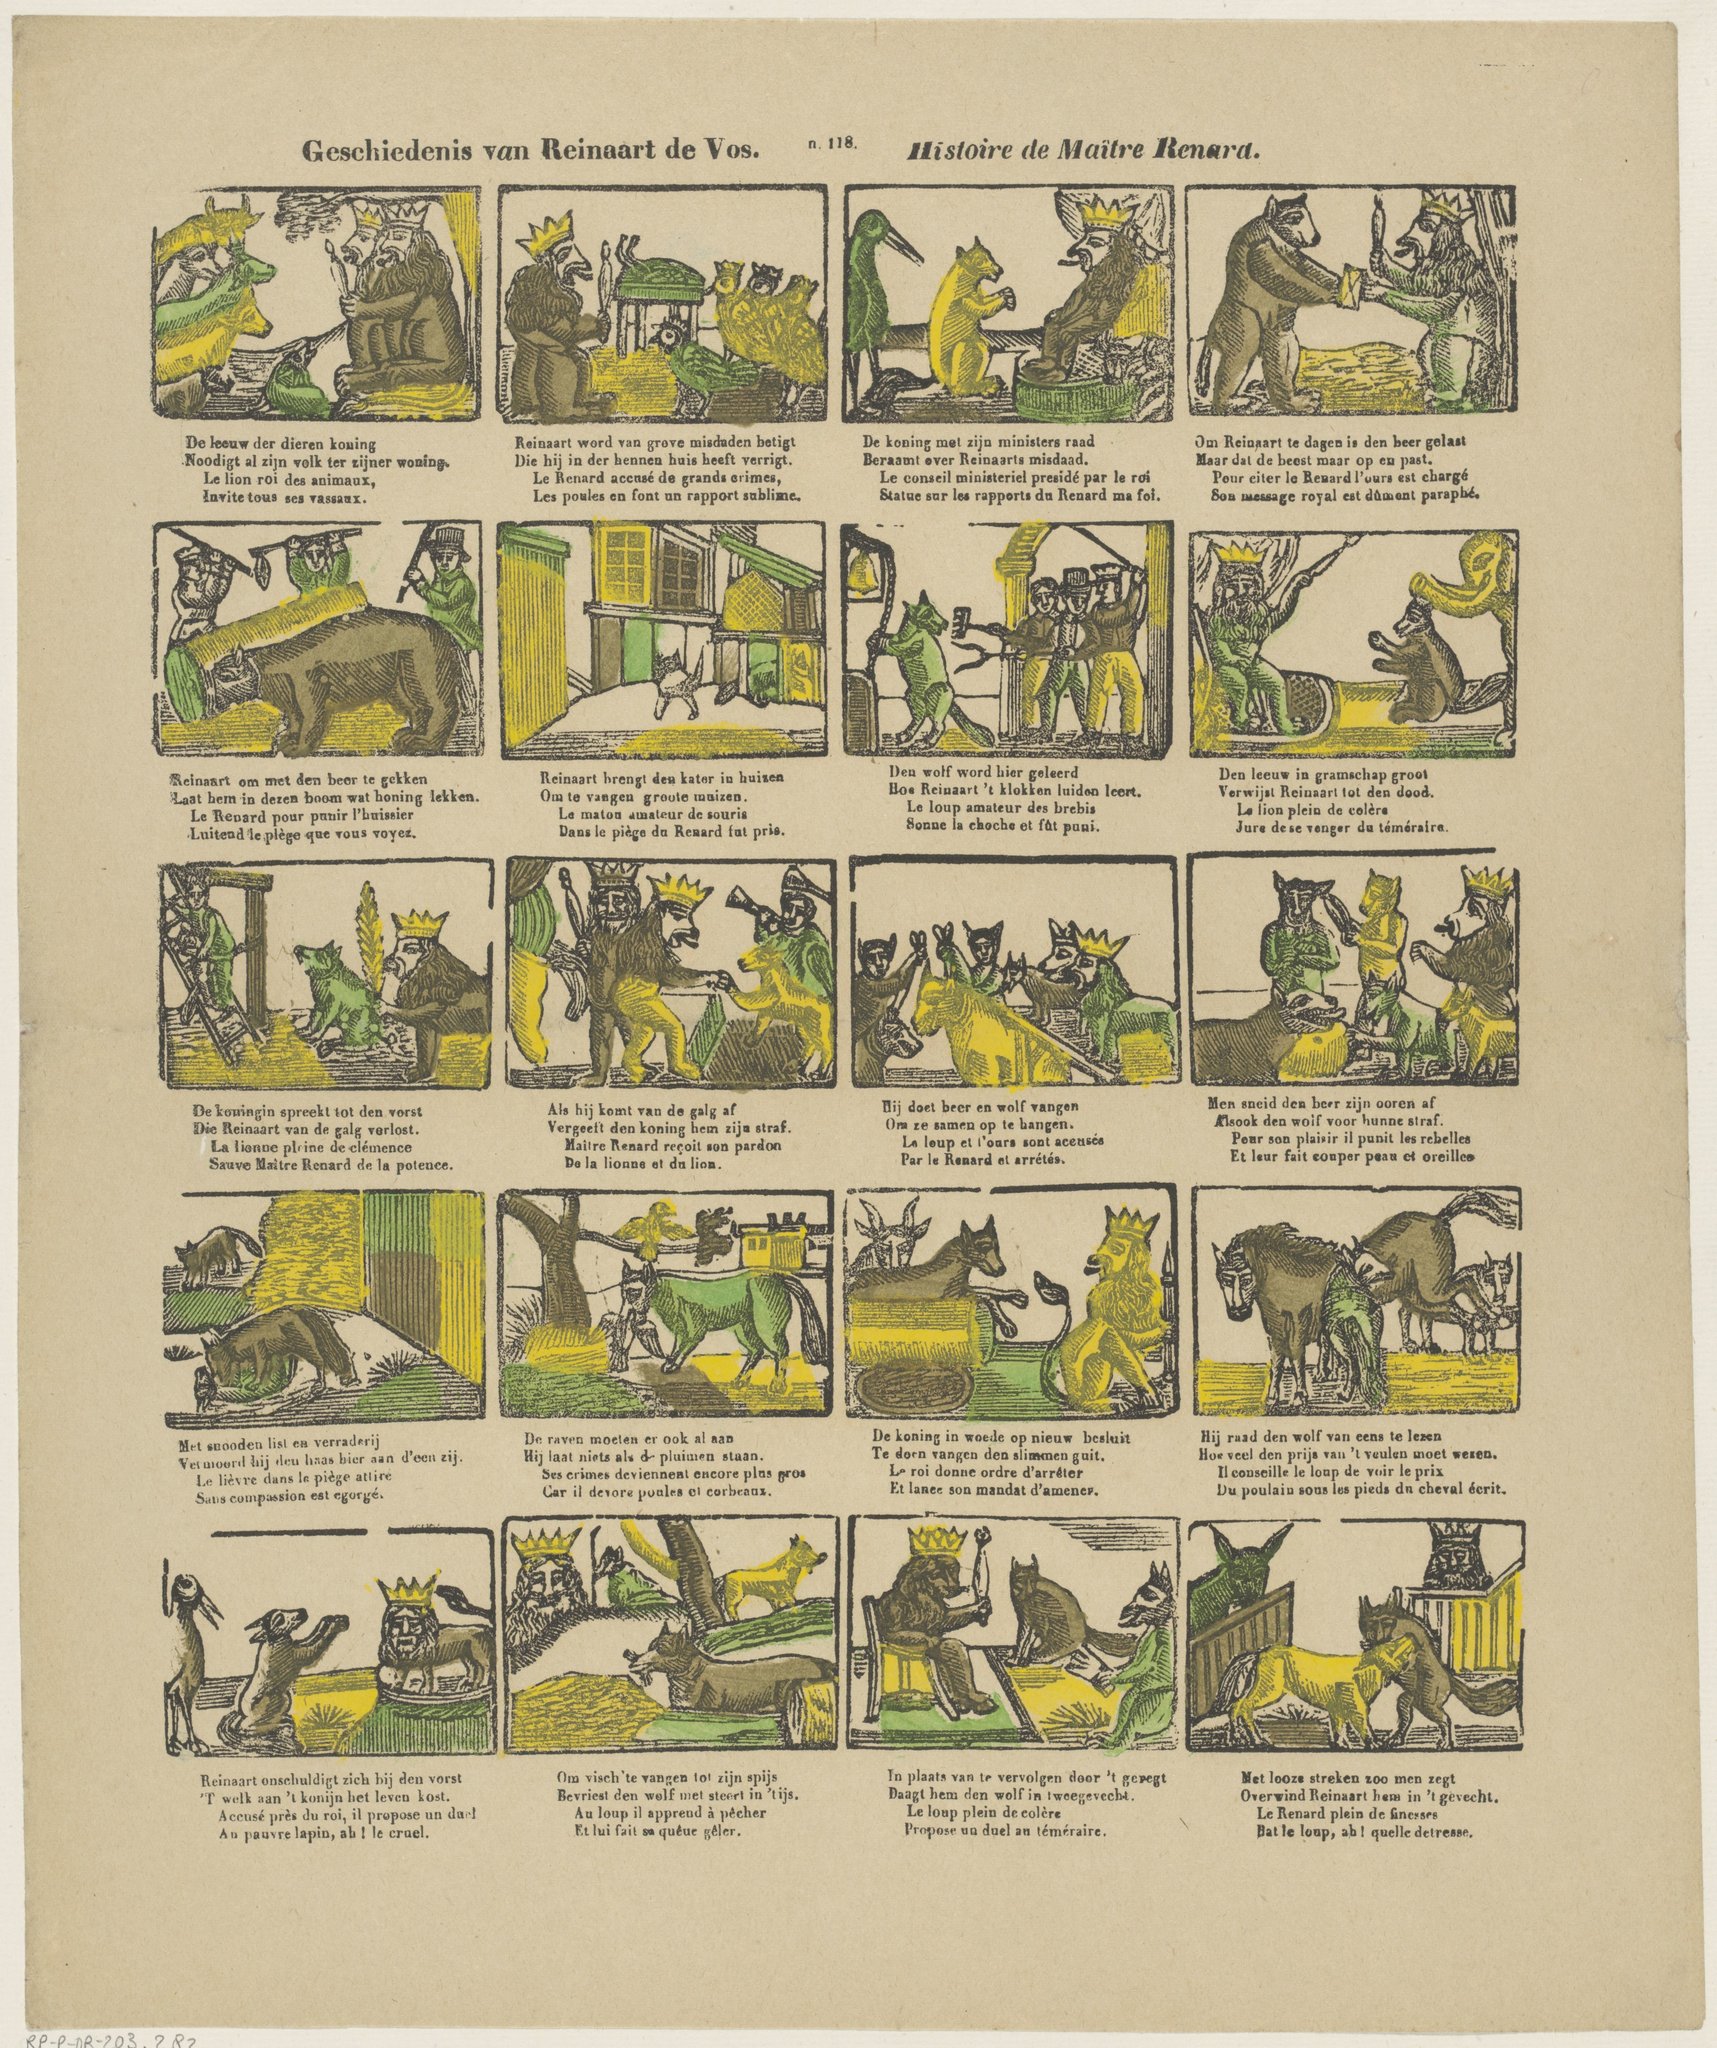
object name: print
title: Geschiedenis van Reinaert de vos / Histoire de mâitre Renard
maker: Anonymous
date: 1856-1900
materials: paper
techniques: colour, letterpress printing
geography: turnhout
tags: fable of reynard the fox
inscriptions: collector's mark: Lugt 2760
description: Blad met 20 voorstellingen uit het epos van Reinaert de vos. Onder elke afbeelding een tweeregelig vers in het Nederlands en in het Frans. Genummerd midden boven: n. 118.